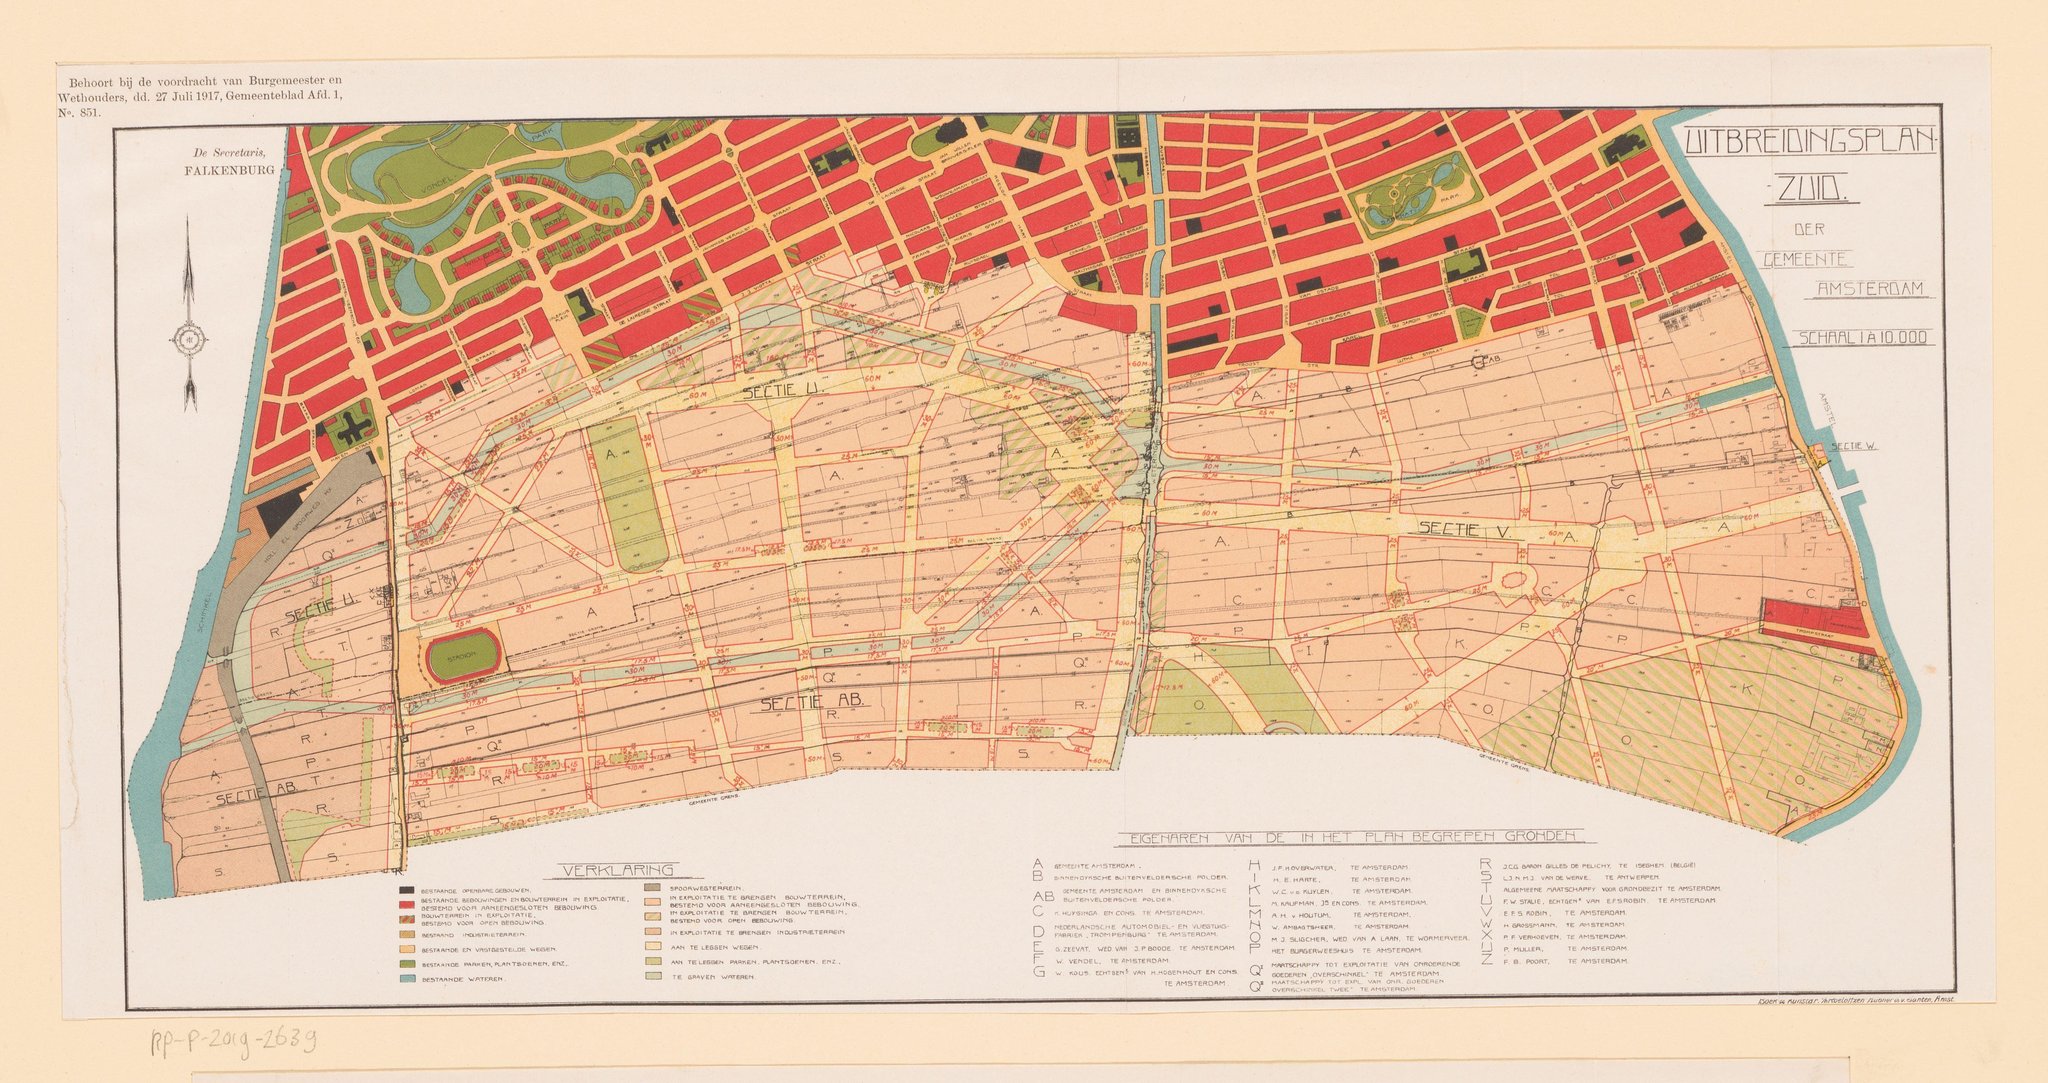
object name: reproduction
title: Uitbreidingsplan Zuid der Gemeente Amsterdam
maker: Anonymous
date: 1917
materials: paper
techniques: offset printed, photolithography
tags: maps of cities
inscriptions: date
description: Linksboven: Behoort bij de voordracht van burgemeester en wethouders, dd. 27 juli 1917.